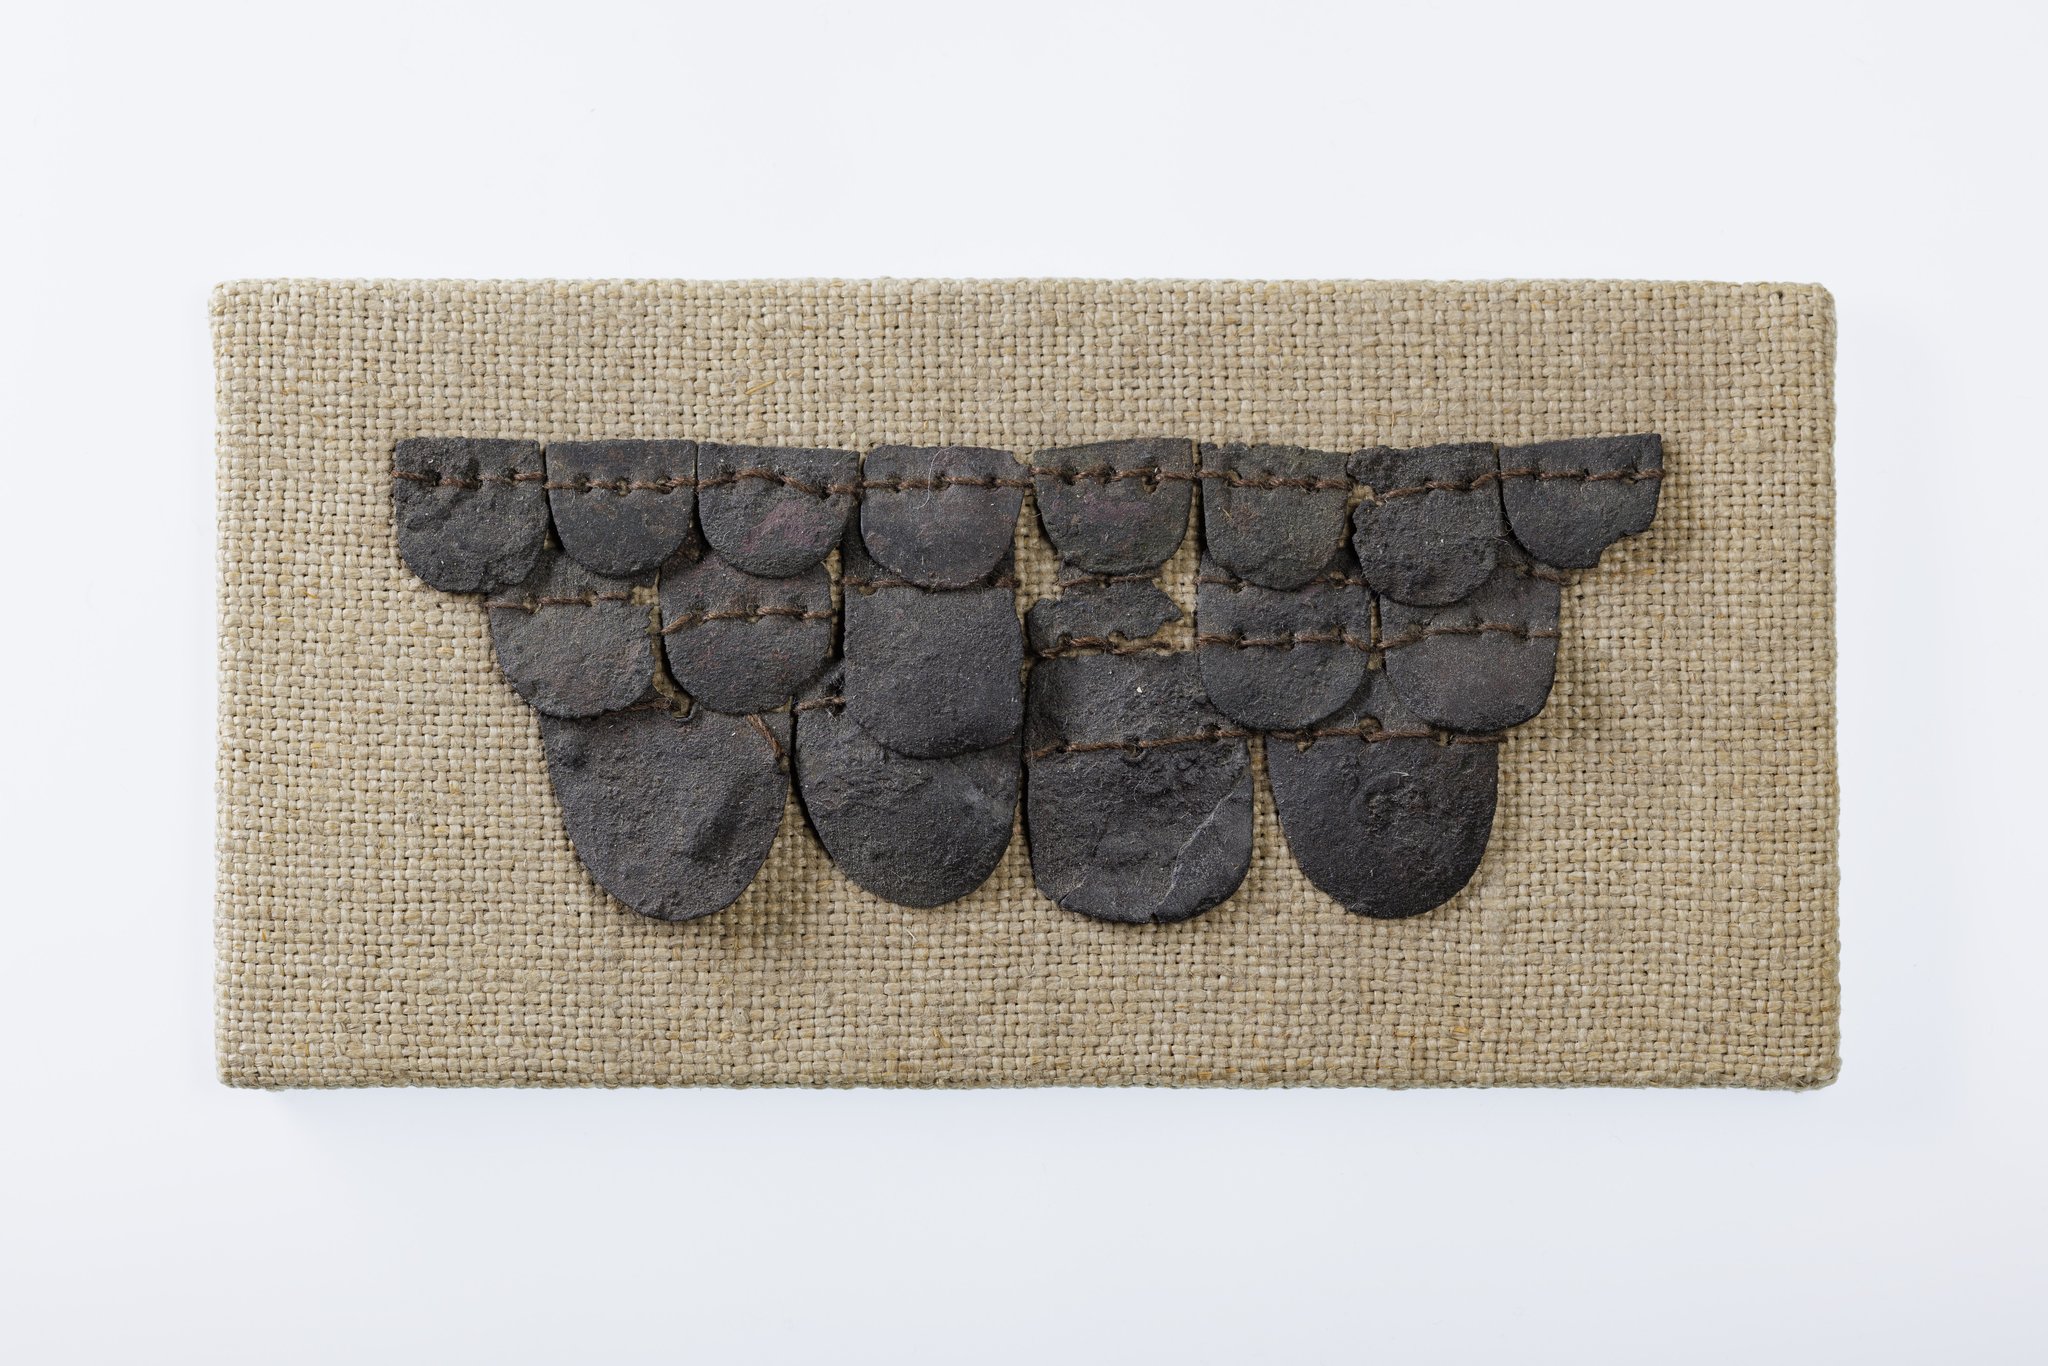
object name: armor scale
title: Armor Scales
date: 589-570 BCE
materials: bronze, copper alloy, iron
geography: egypt